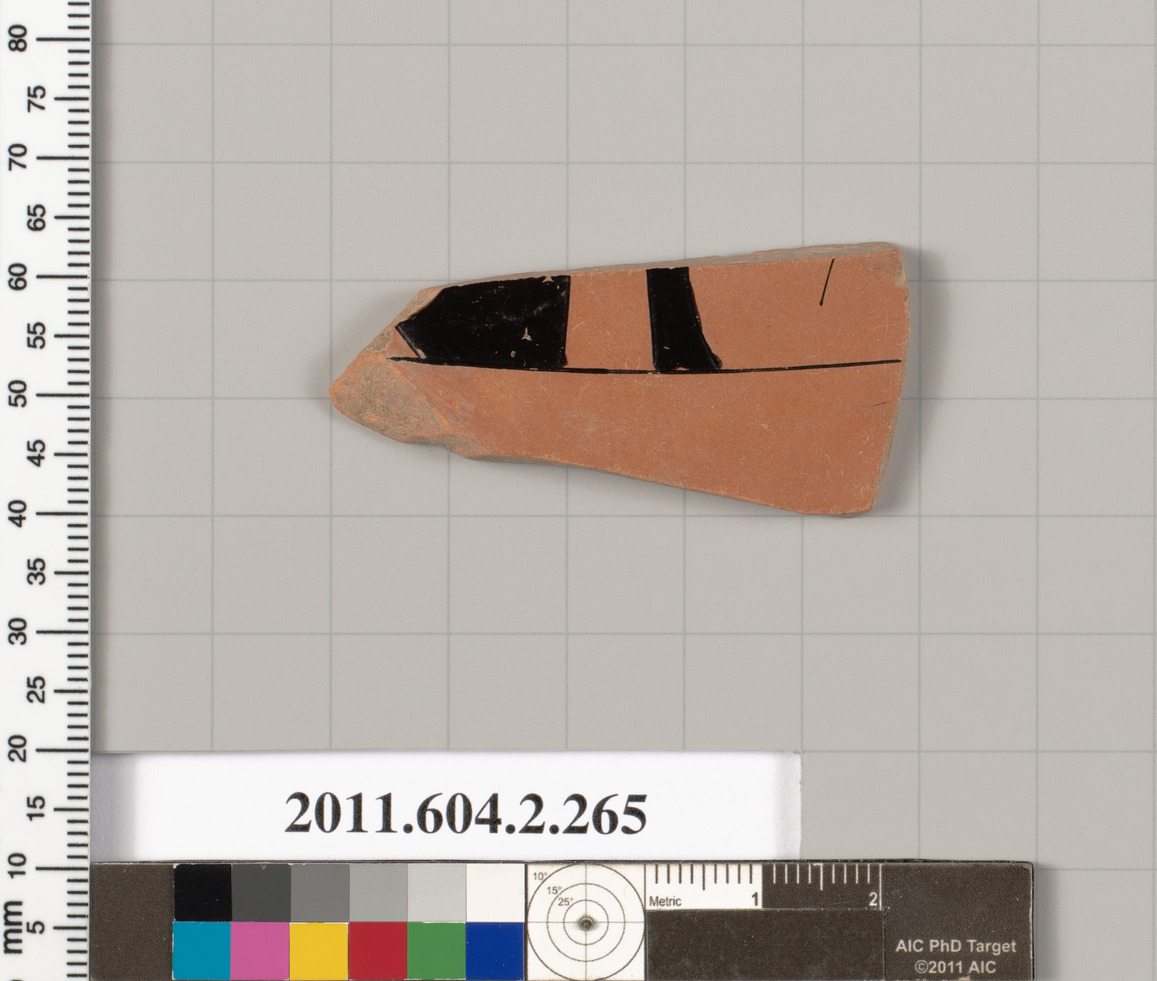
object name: stamnos fragment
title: Terracotta fragment of a stamnos (jar)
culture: greek, attic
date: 490-470 BCE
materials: terracotta